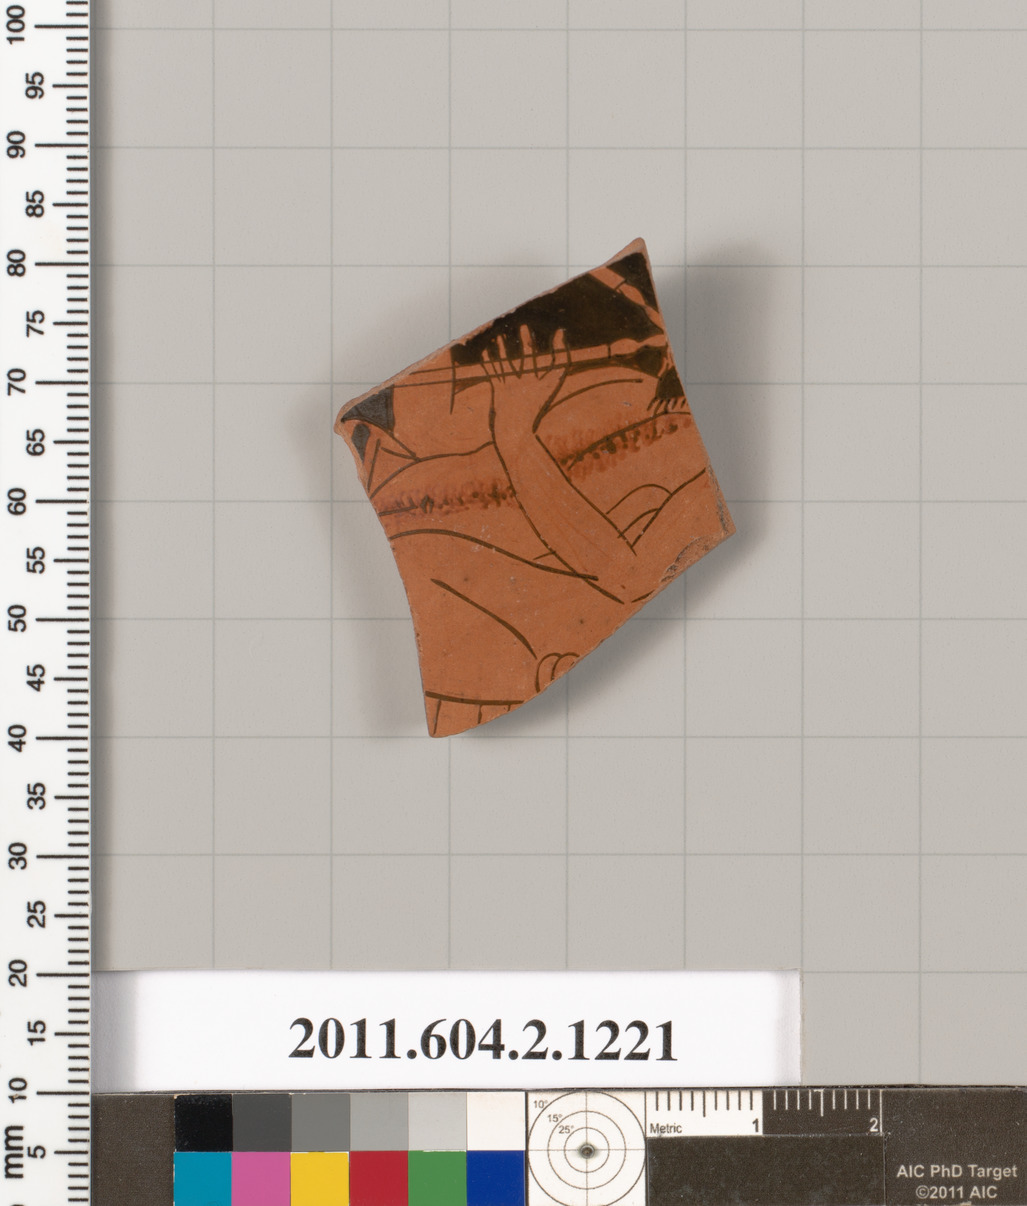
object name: kantharos fragment head vase or rhyton fragment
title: Terracotta fragment from a kantharos: head vase? or rhyton?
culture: greek, attic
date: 490-470 BCE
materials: terracotta